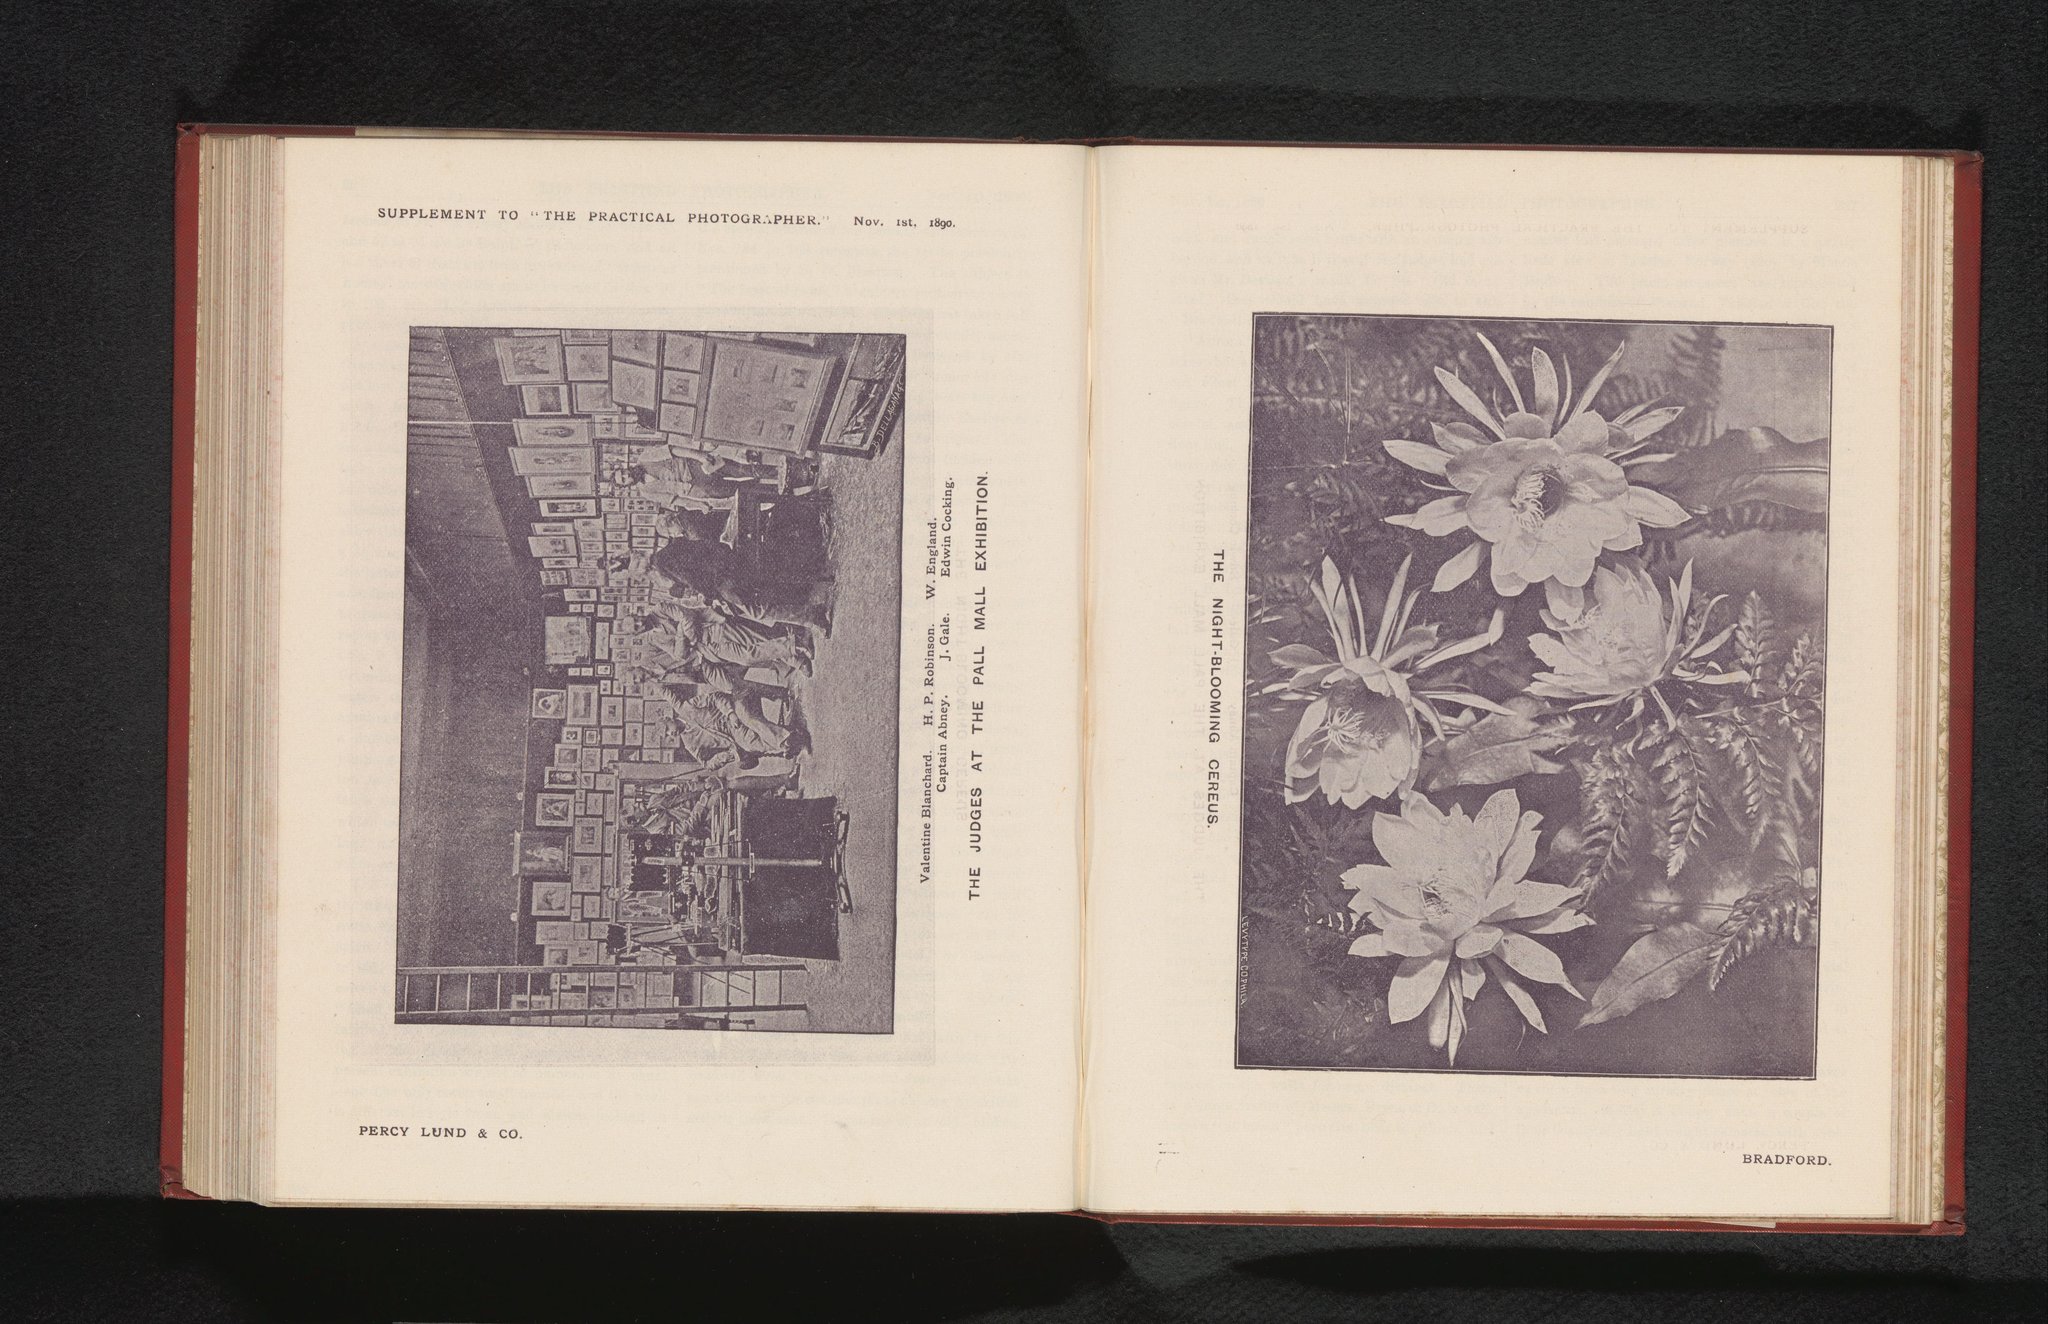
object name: photomechanical print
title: Jurering van de Pall Mall Exhibition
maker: Anonymous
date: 1885-1890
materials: paper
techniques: autotype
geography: bradford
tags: jury ~ art contest, anonymous historical persons portrayed in a group, in a group-portrait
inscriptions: inscription: ‘SUPPLEMENT TO "THE PRACTICAL PHOTOGRAPHER." Nov. 1st, 1890.’, name: ‘Valentine Blanchard. H. P. Robinson. W. England./ Captain Abney. J. Gale. Edwin Cocking.’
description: Prent op tweede ongenummerde pagina na pagina 266.